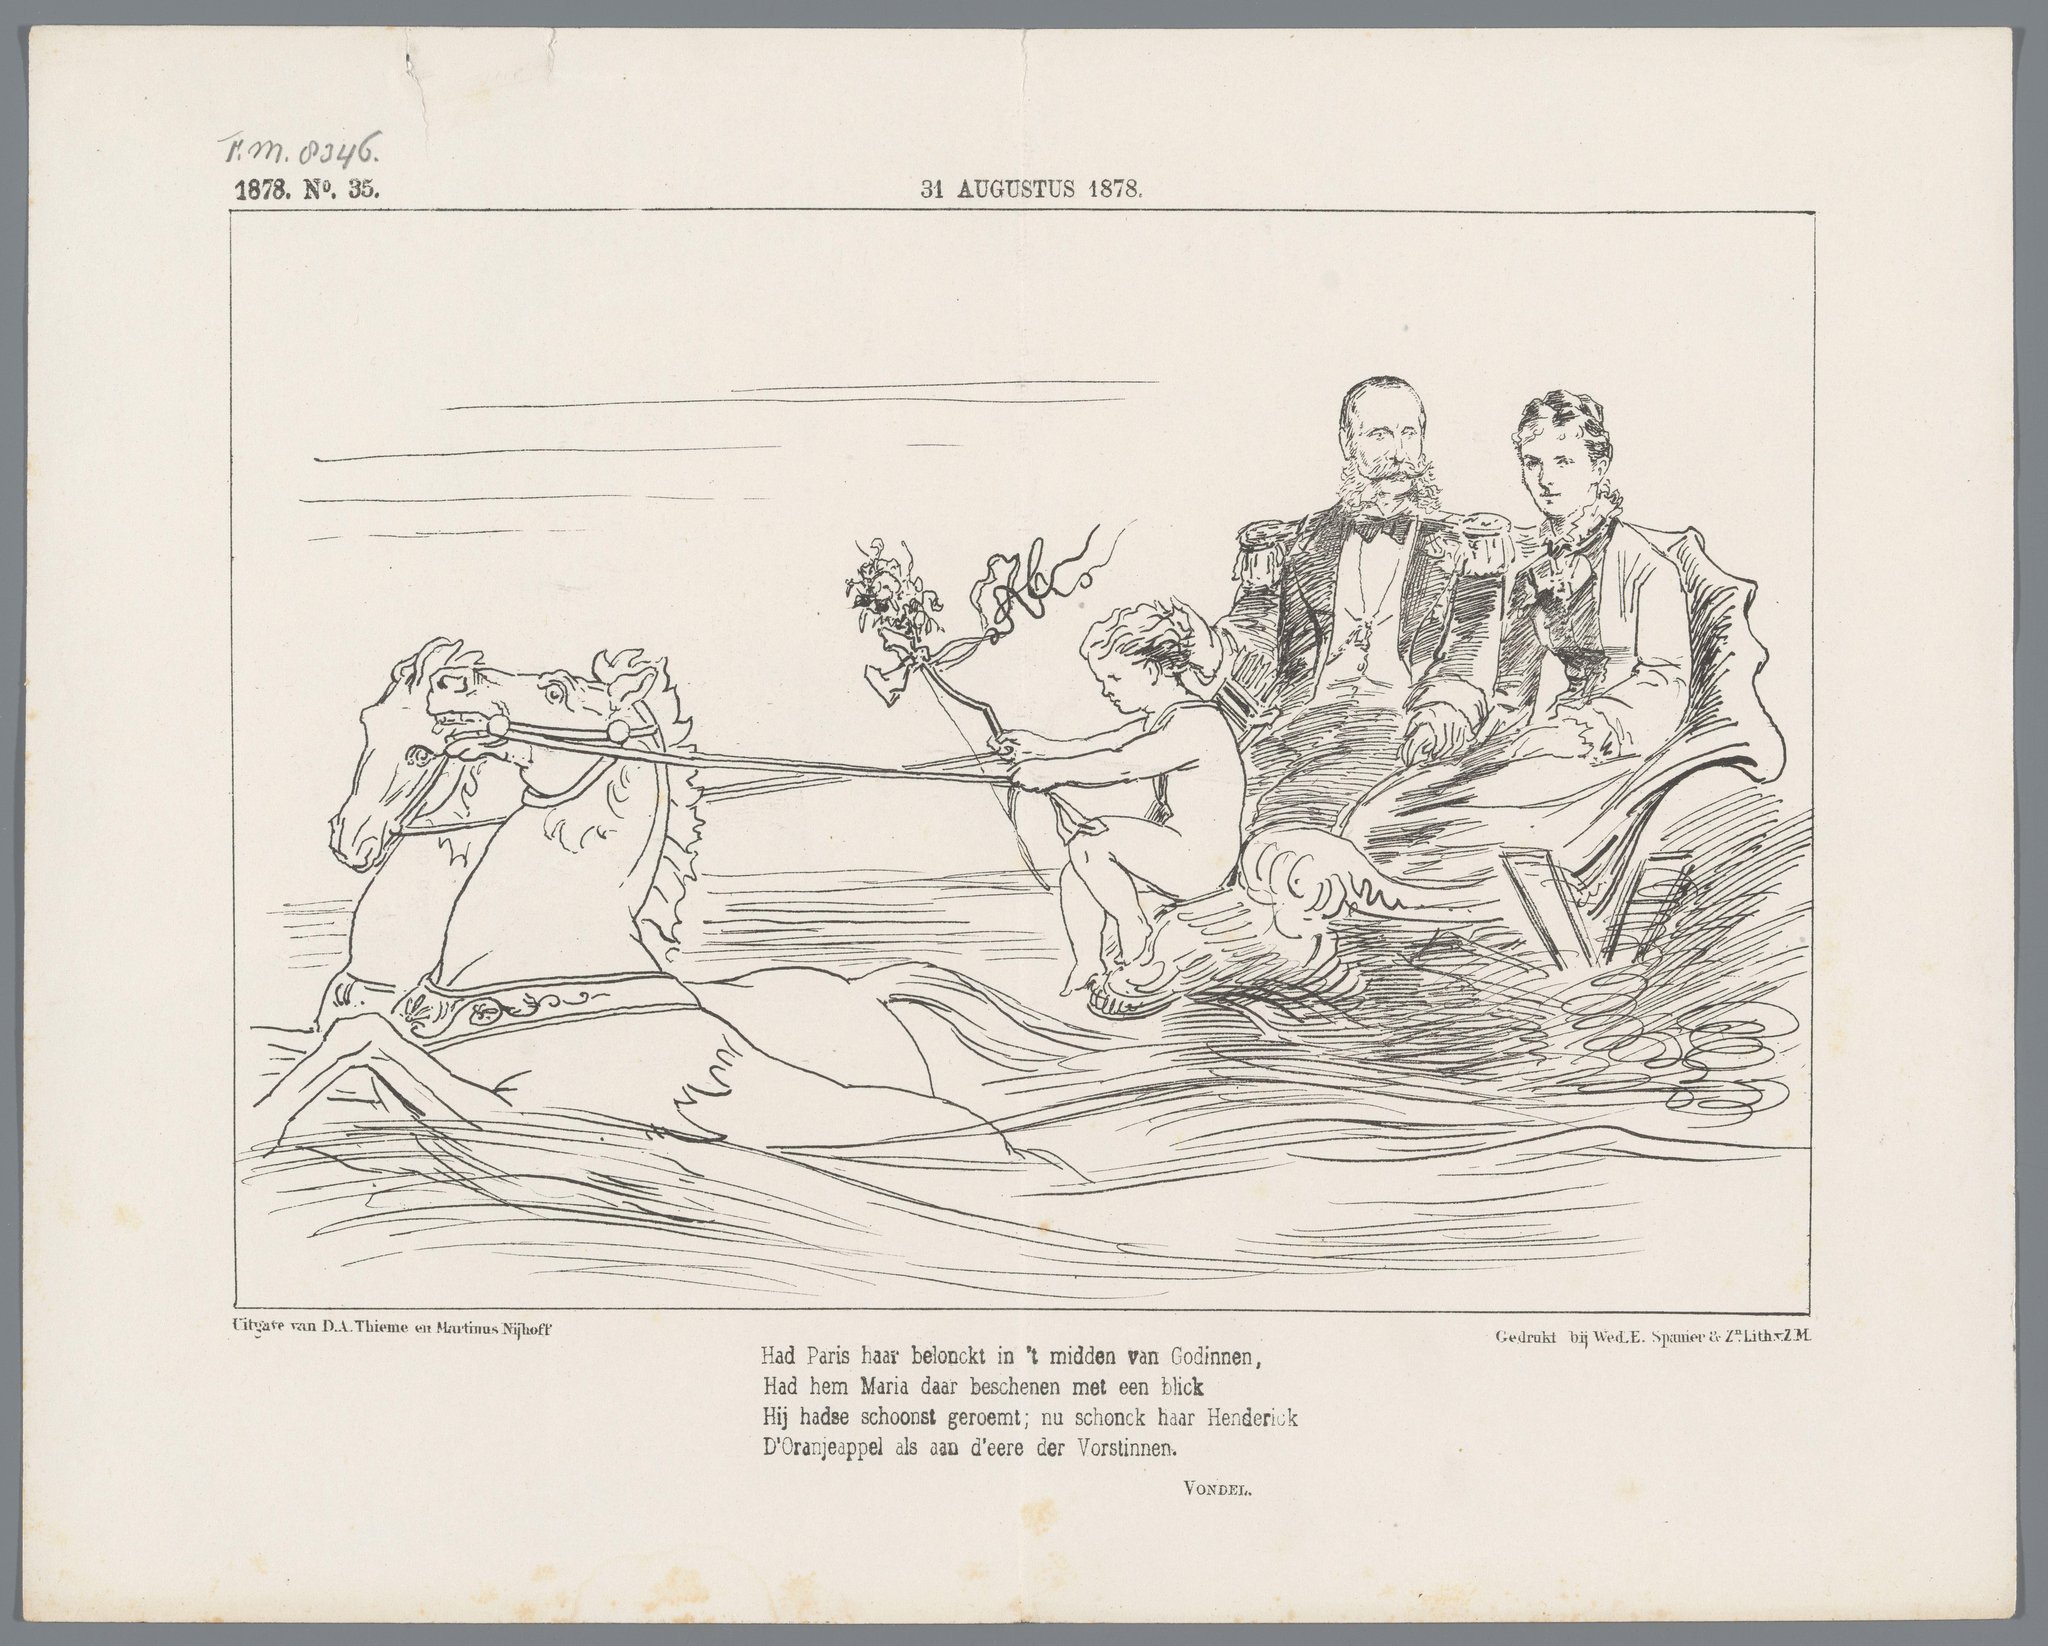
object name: print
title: Spotprent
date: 1878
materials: paper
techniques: lithograph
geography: netherlands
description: Spotprent. Plaat verschenen bij het weekblad De Nederlandsche Spectator, nr. 35, 1878.